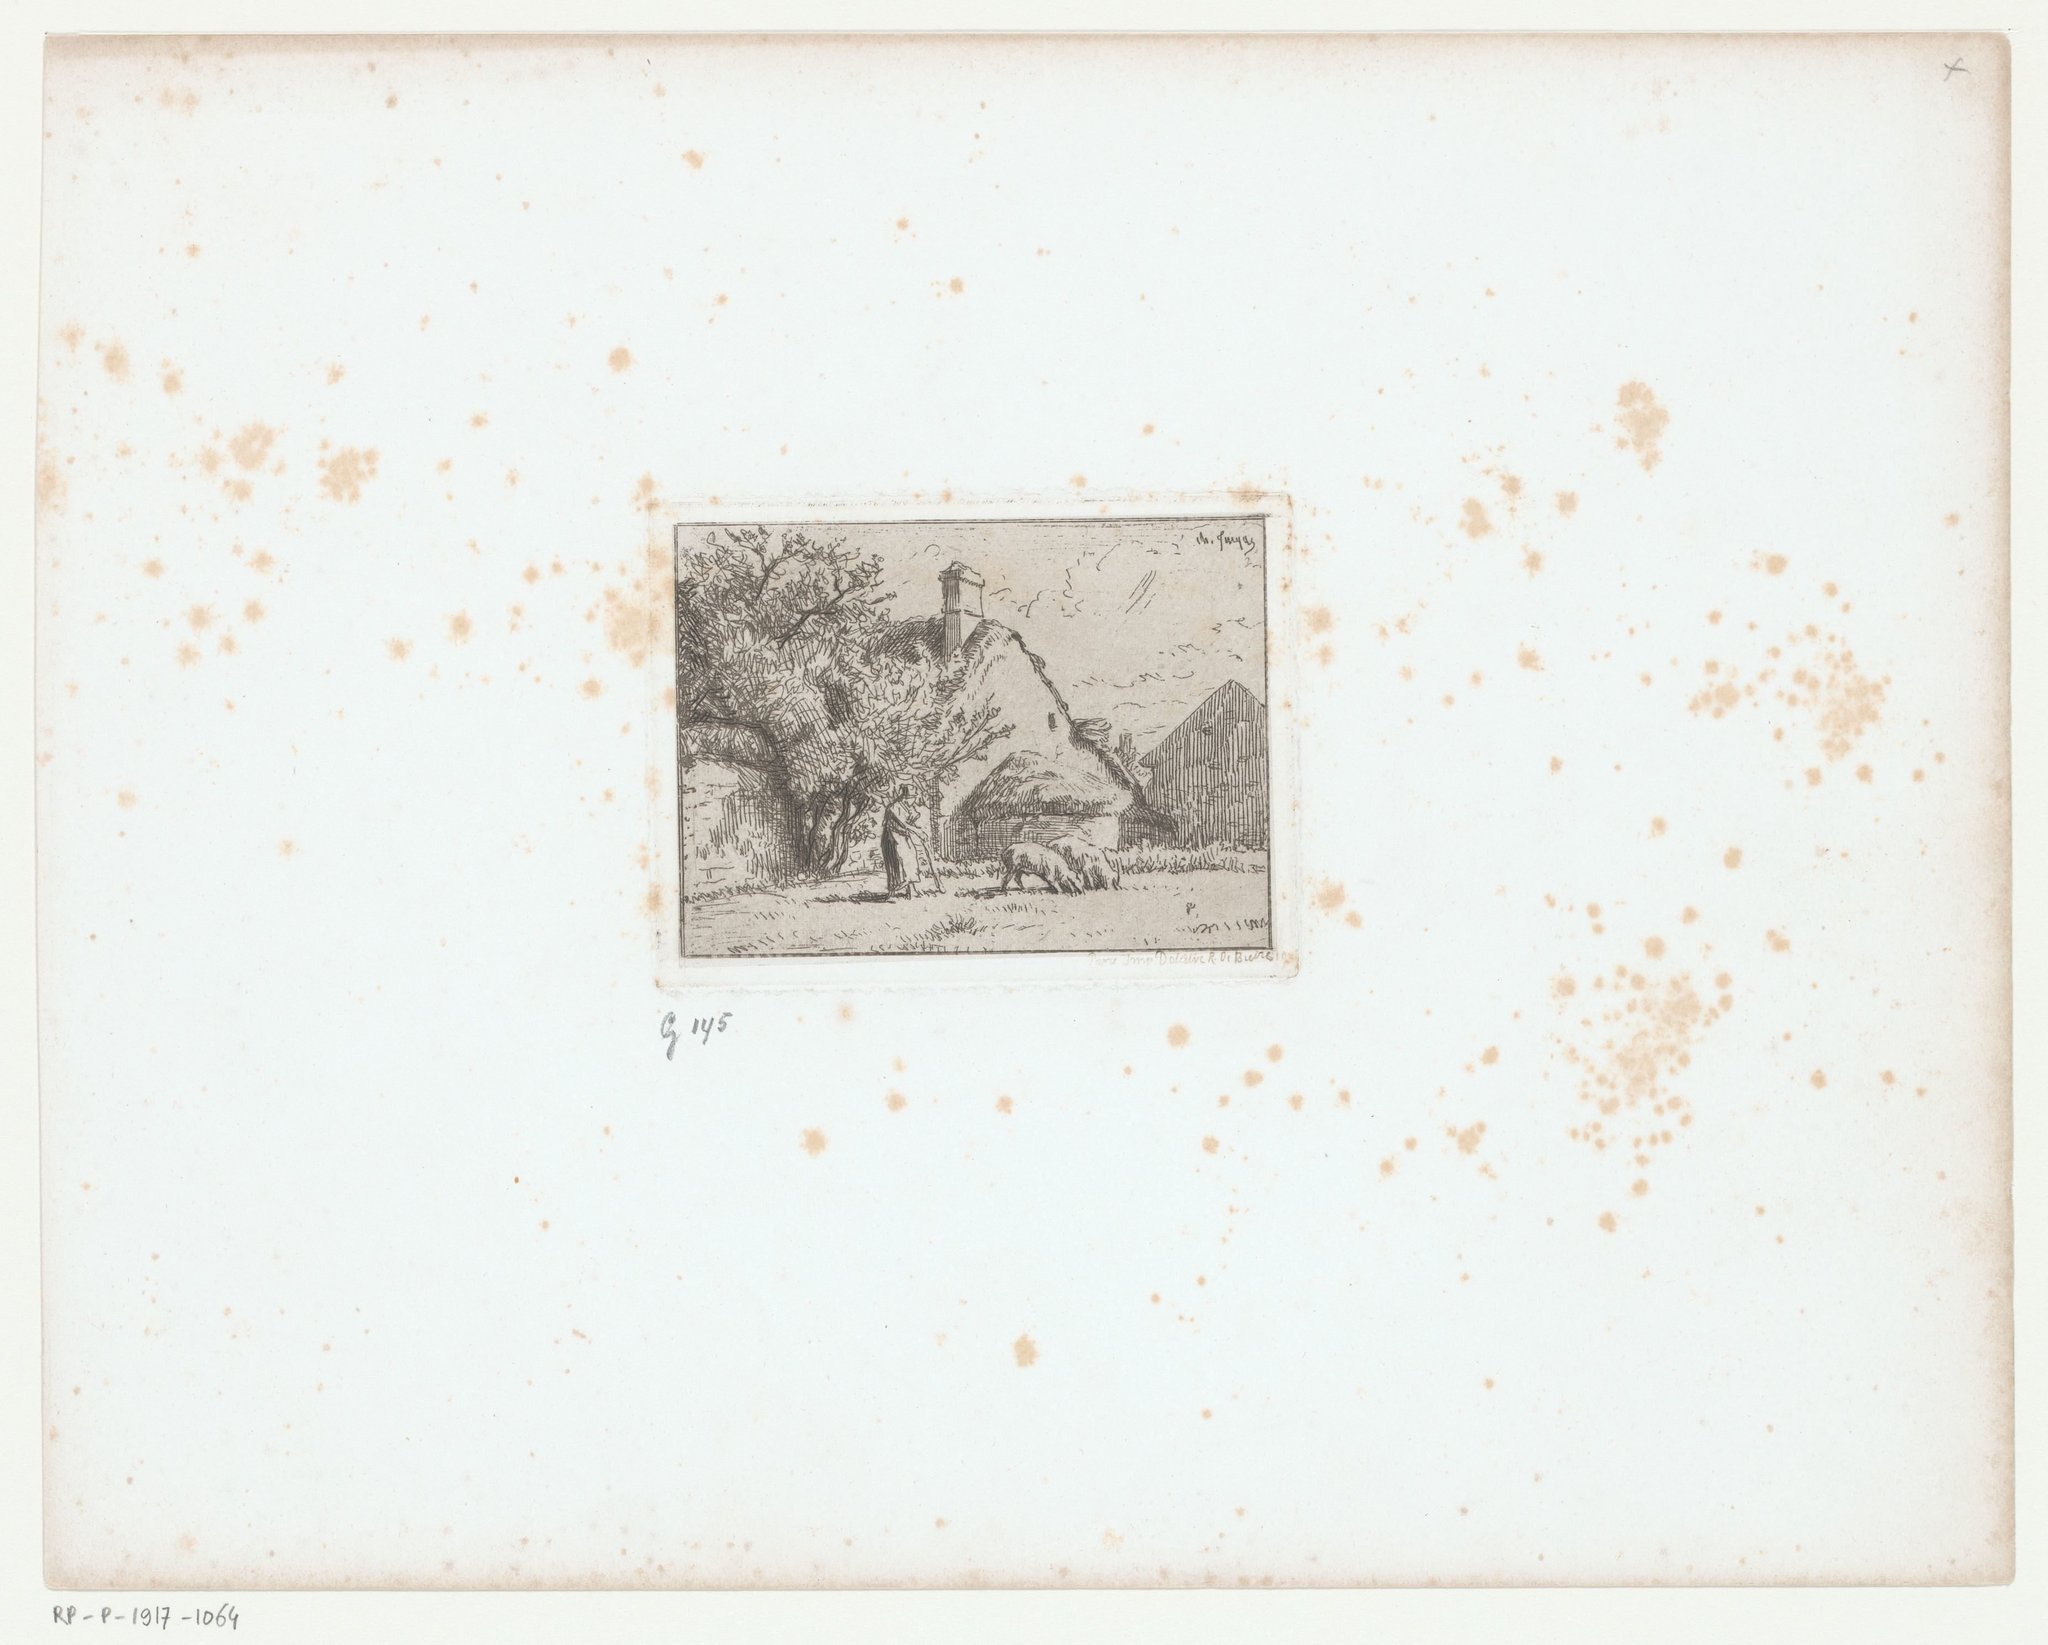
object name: print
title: Varkenshoedster voor een boerderij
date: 1849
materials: paper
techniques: etching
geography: paris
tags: pig, herd, flock, farm (building)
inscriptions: collector's mark: Lugt 2233